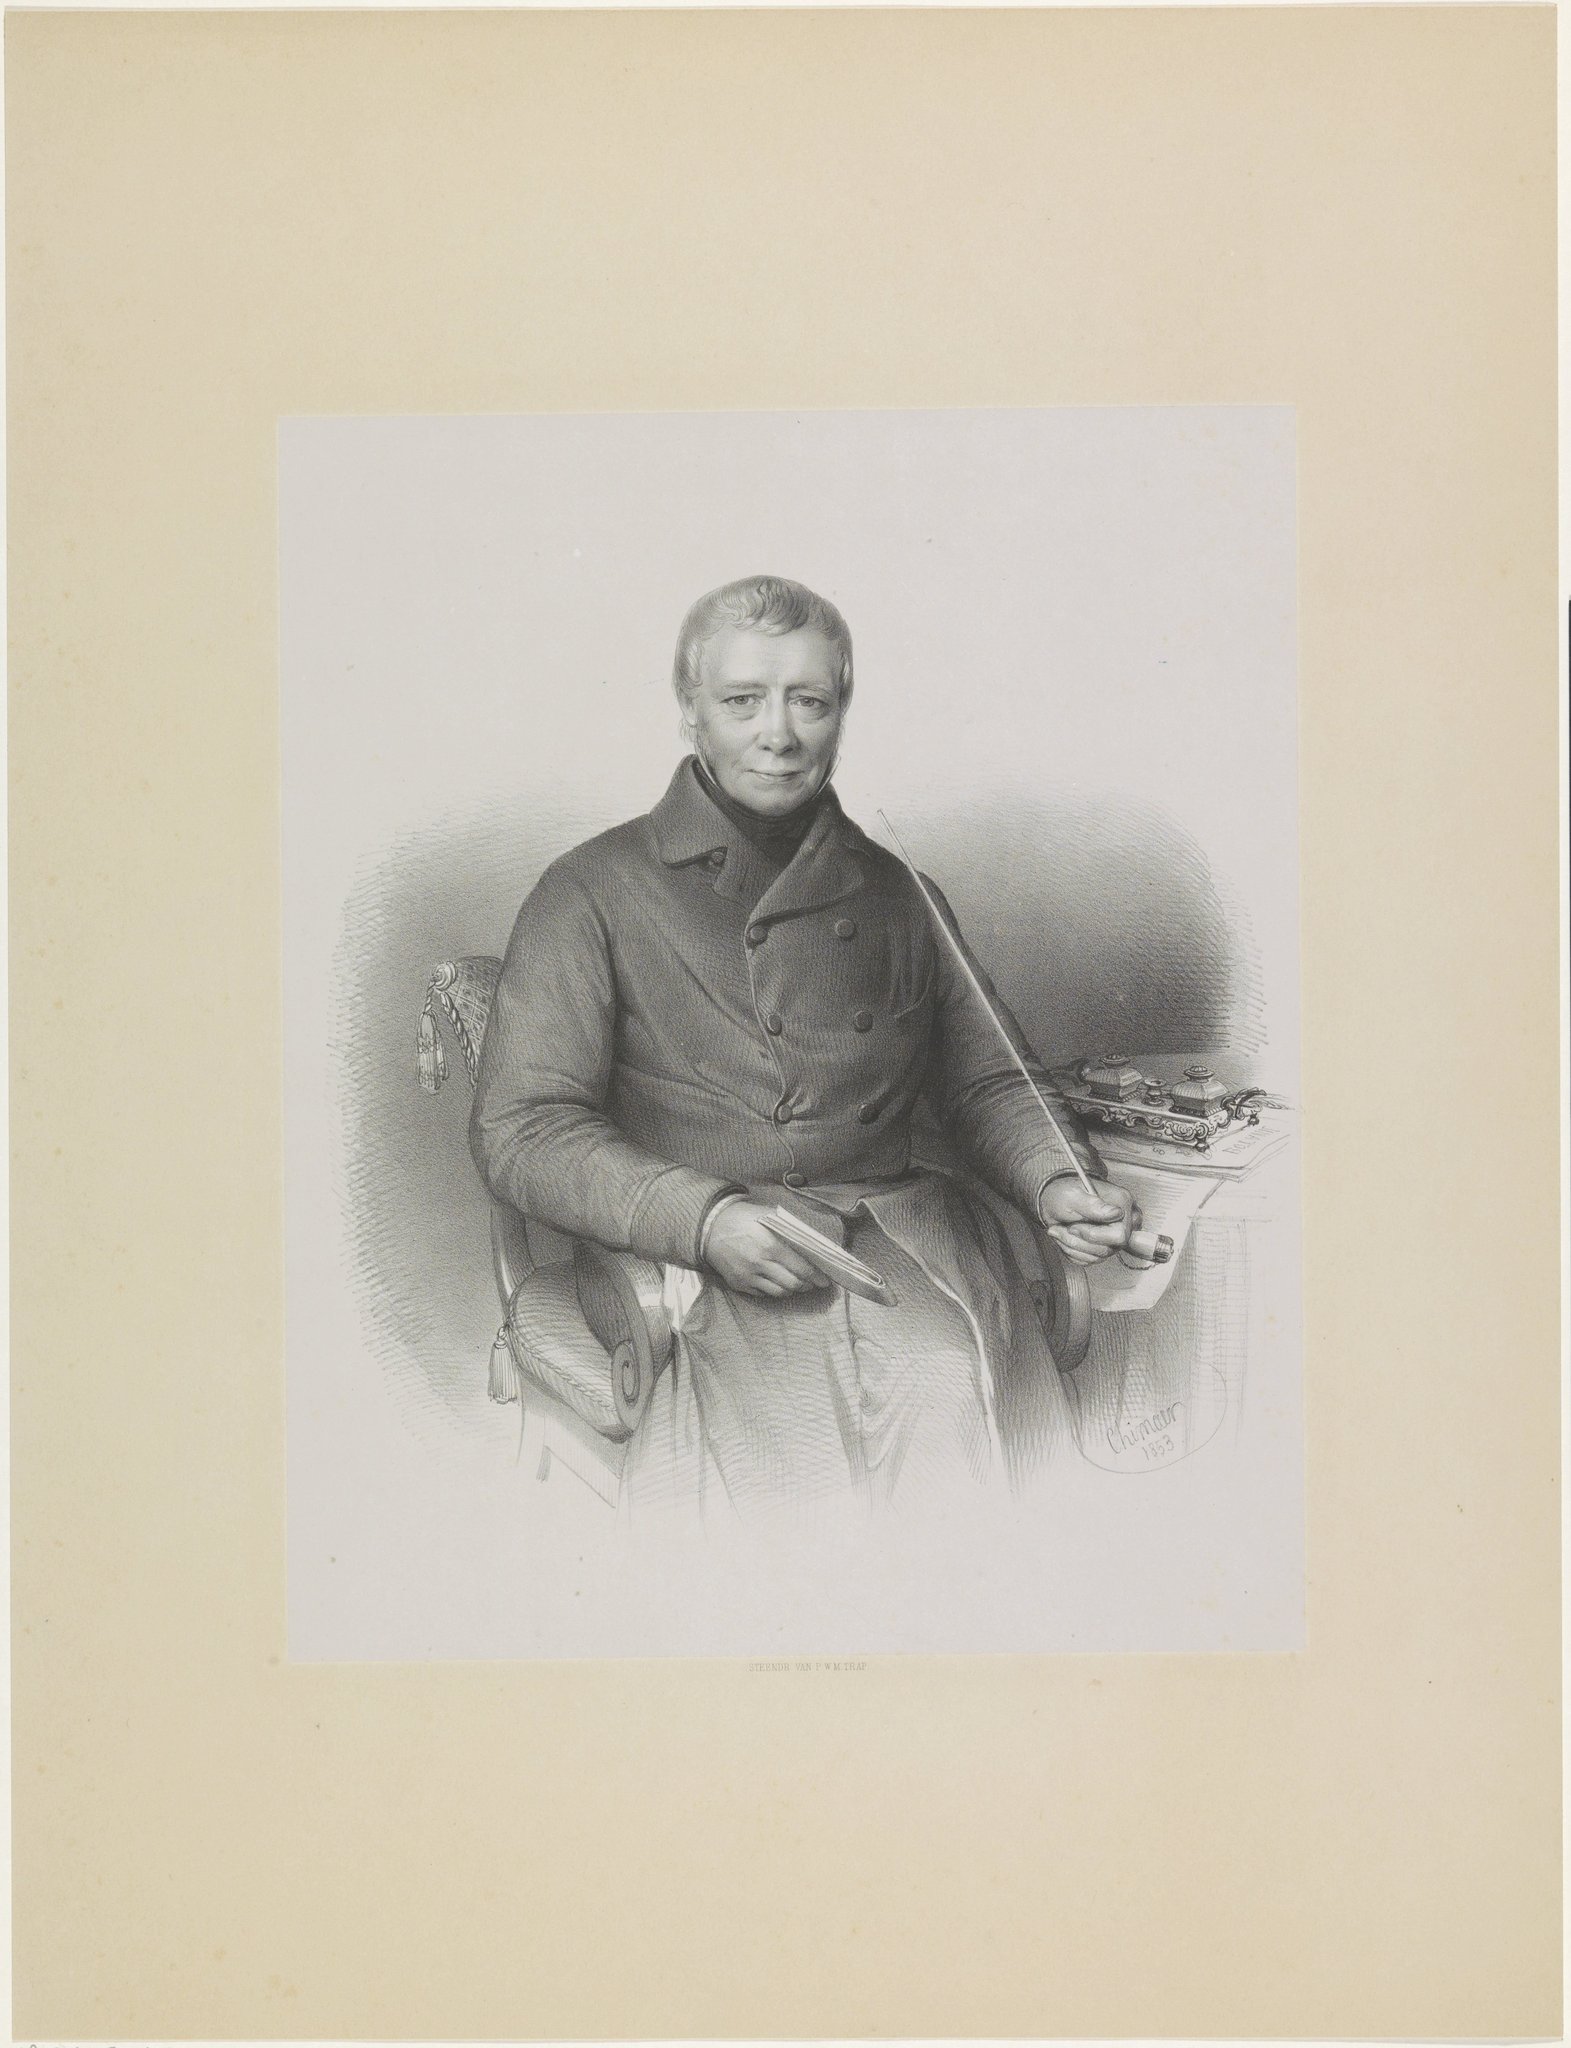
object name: print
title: Portret van Andr. Will. Pottum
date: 1853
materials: paper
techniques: lithograph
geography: leiden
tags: ink (+ scholar, scientist in non-work situations), pipe ~ tobacco, historical persons (+ three-quarter length portrait)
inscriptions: collector's mark: Lugt 2228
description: De geportretteerde zit op een stoel en heeft een Goudse stenen pijp in zijn linkerhand. In zijn rechterhand heeft hij een dun boek. Naast hem staat een tafel met daarop een inkstel en enkele vellen papier. Op een van de vellen staat: 'Botanie' in spiegelschrift.